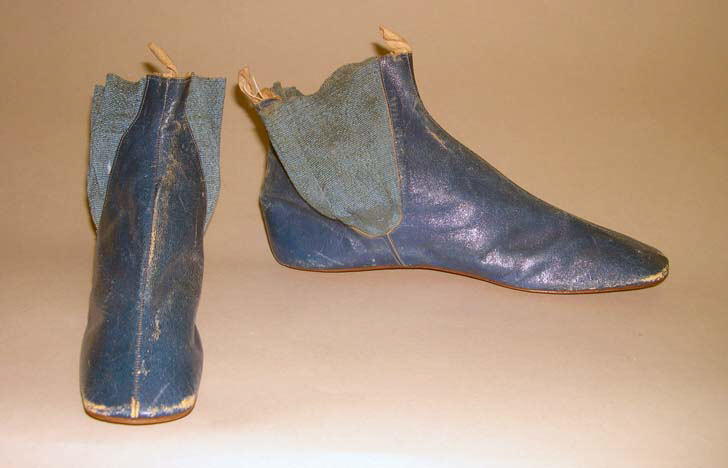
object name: boot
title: Boots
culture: british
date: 1801-1833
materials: leather